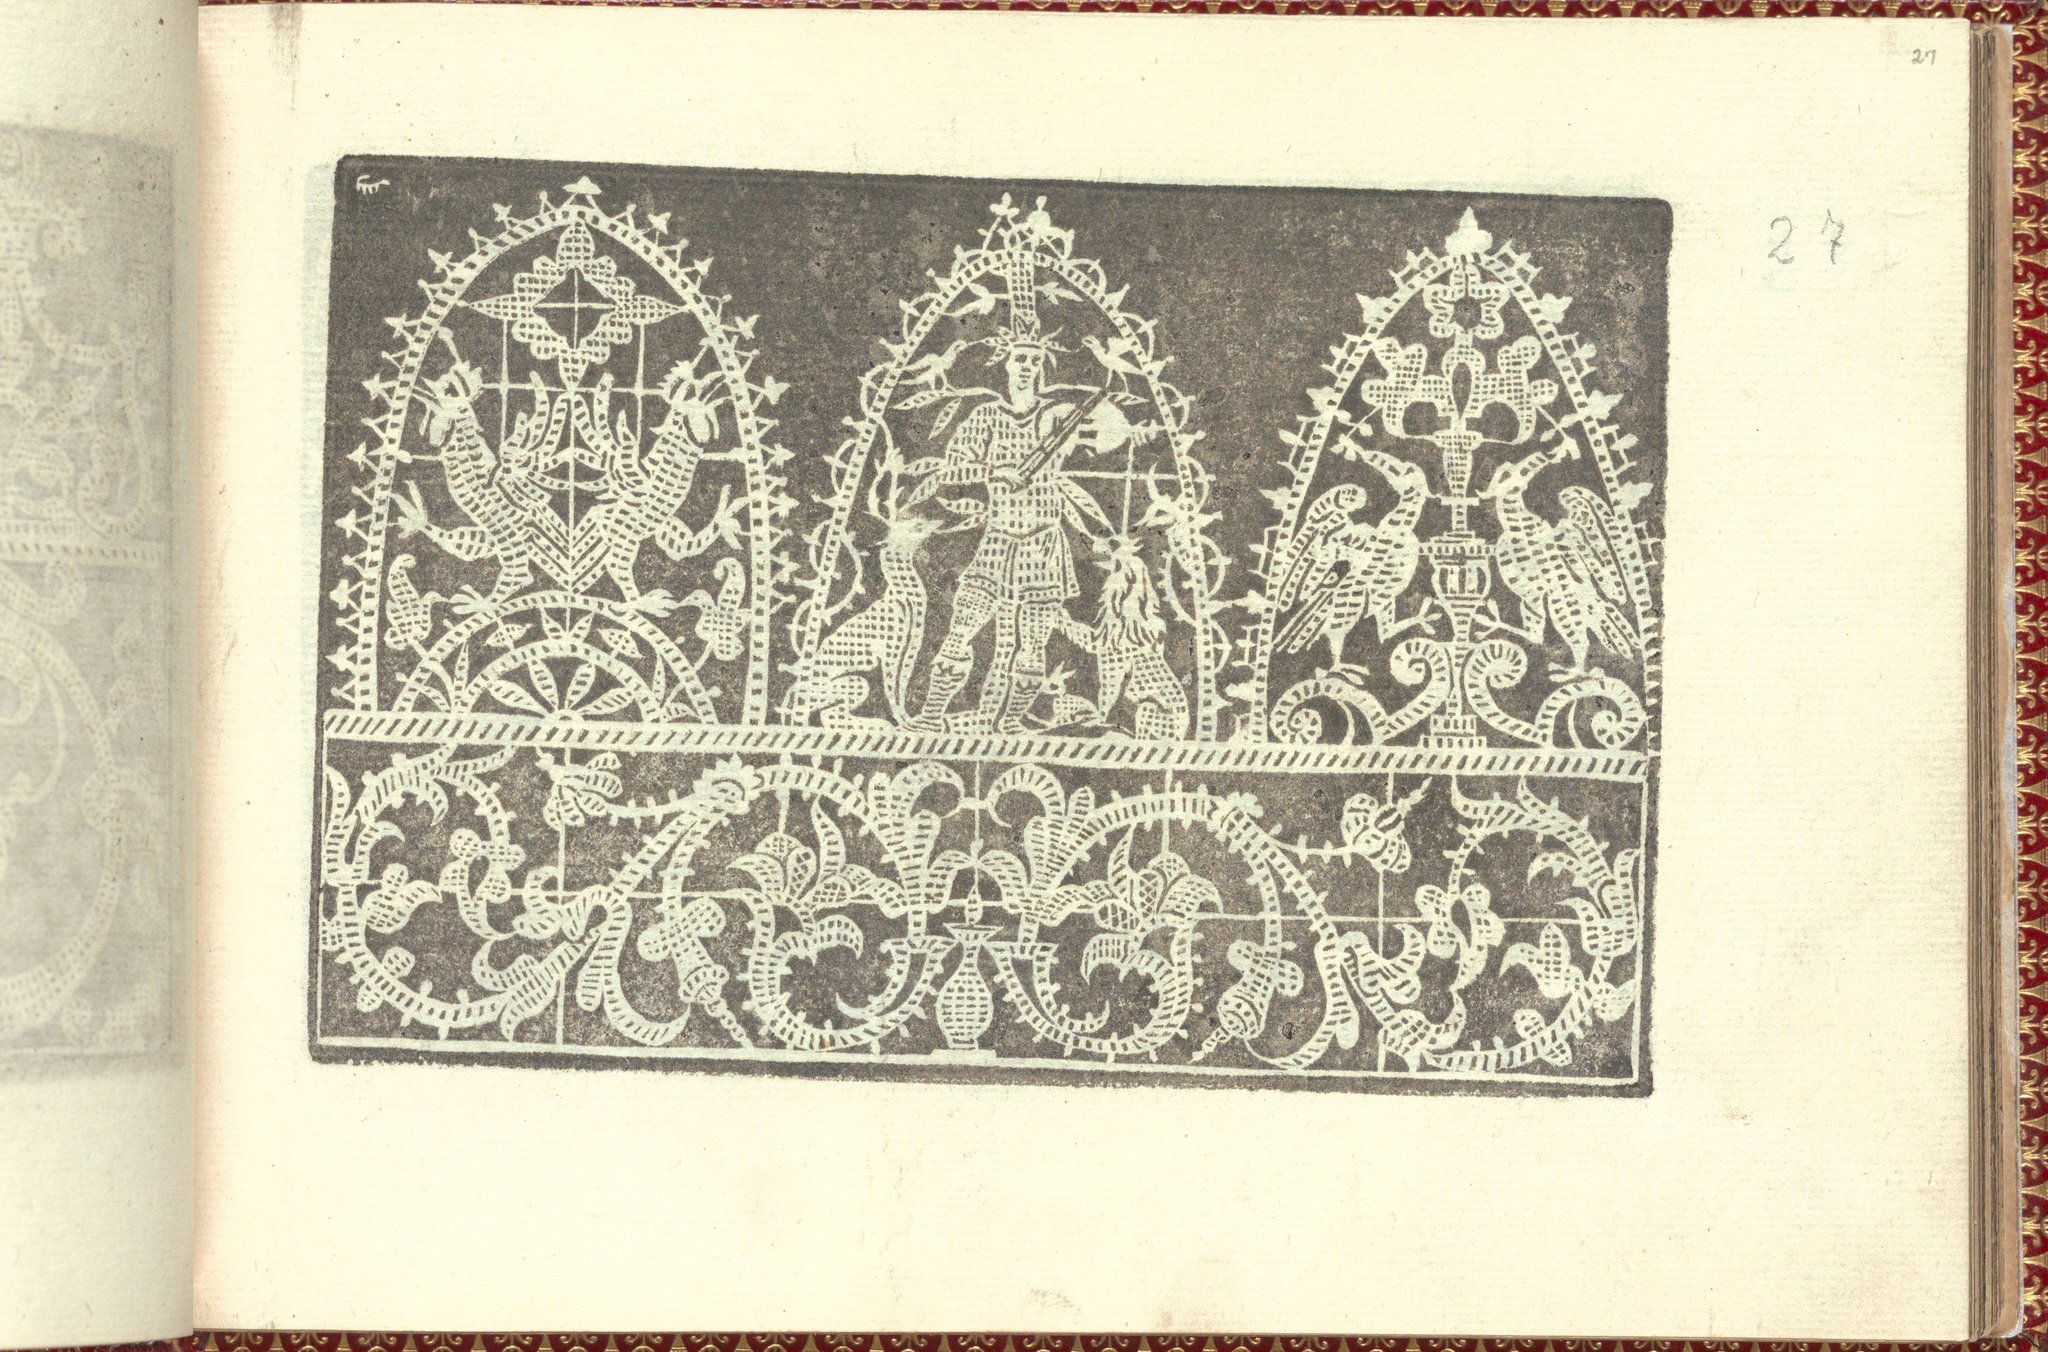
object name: book print ornament architecture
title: Corona delle Nobili et Virtuose Donne: Libro I-IV, page 27 (recto)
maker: cesare vecellio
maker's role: publisher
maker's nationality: italian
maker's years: 1521-1601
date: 1601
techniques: woodcut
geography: italy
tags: birds,ornament,men